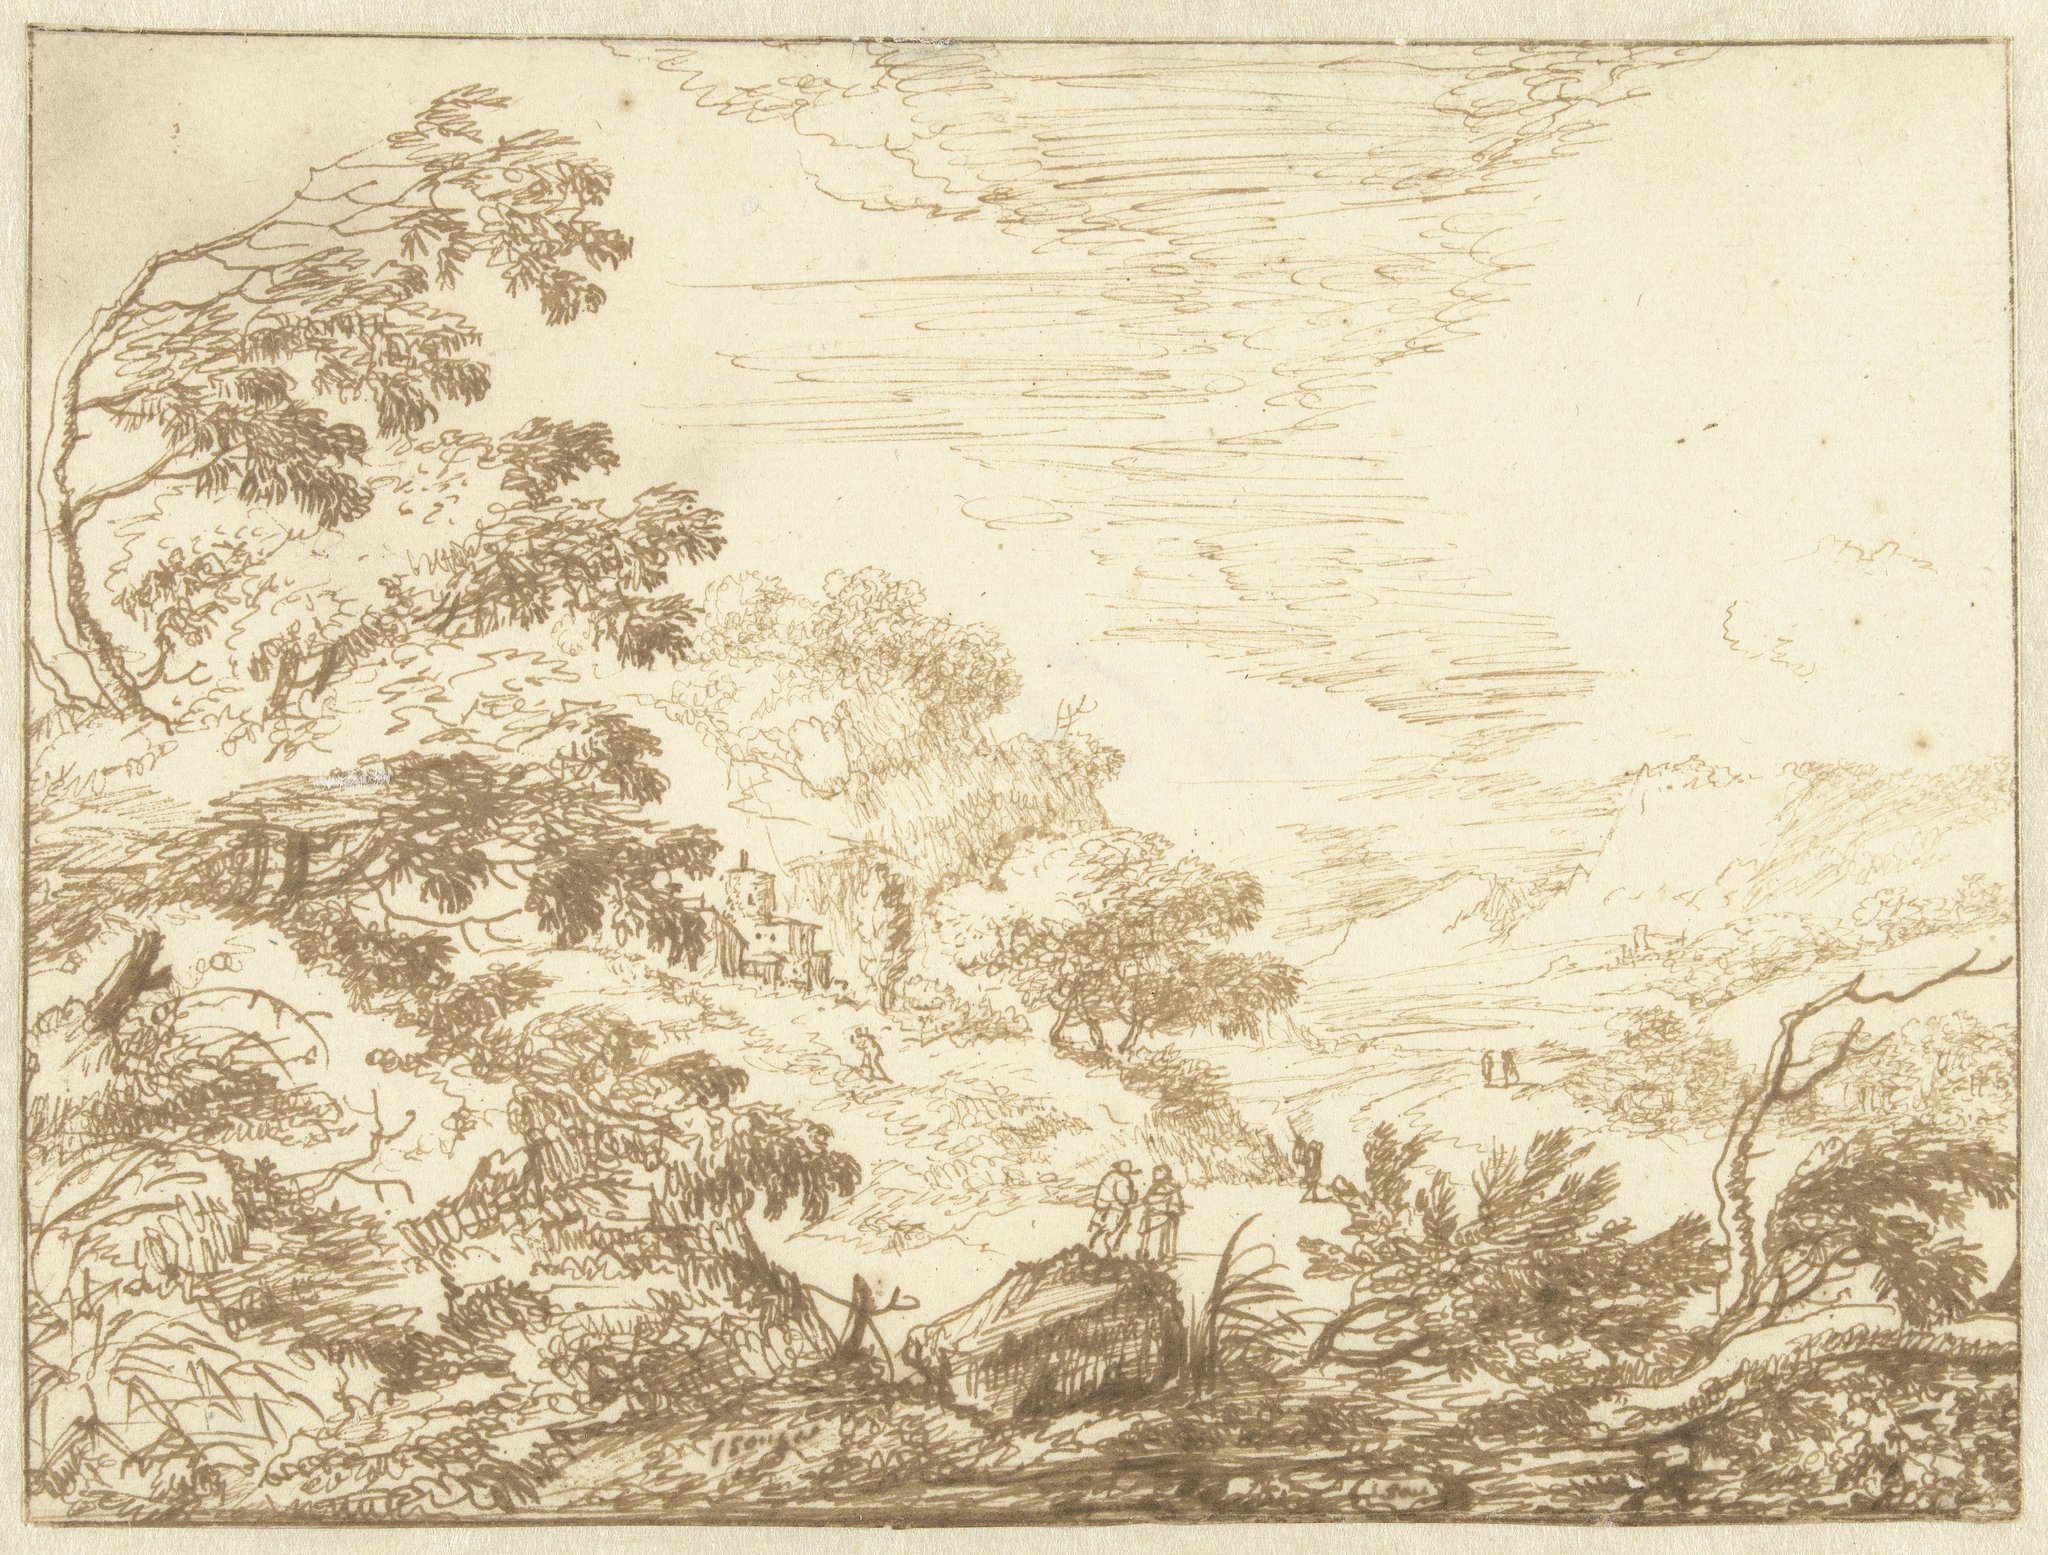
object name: drawing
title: Bergachtig landschap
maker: jan gabrielsz. sonjé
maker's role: draughtsman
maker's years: 1625-1707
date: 1635-1707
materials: ink, paper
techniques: pen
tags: low hill country